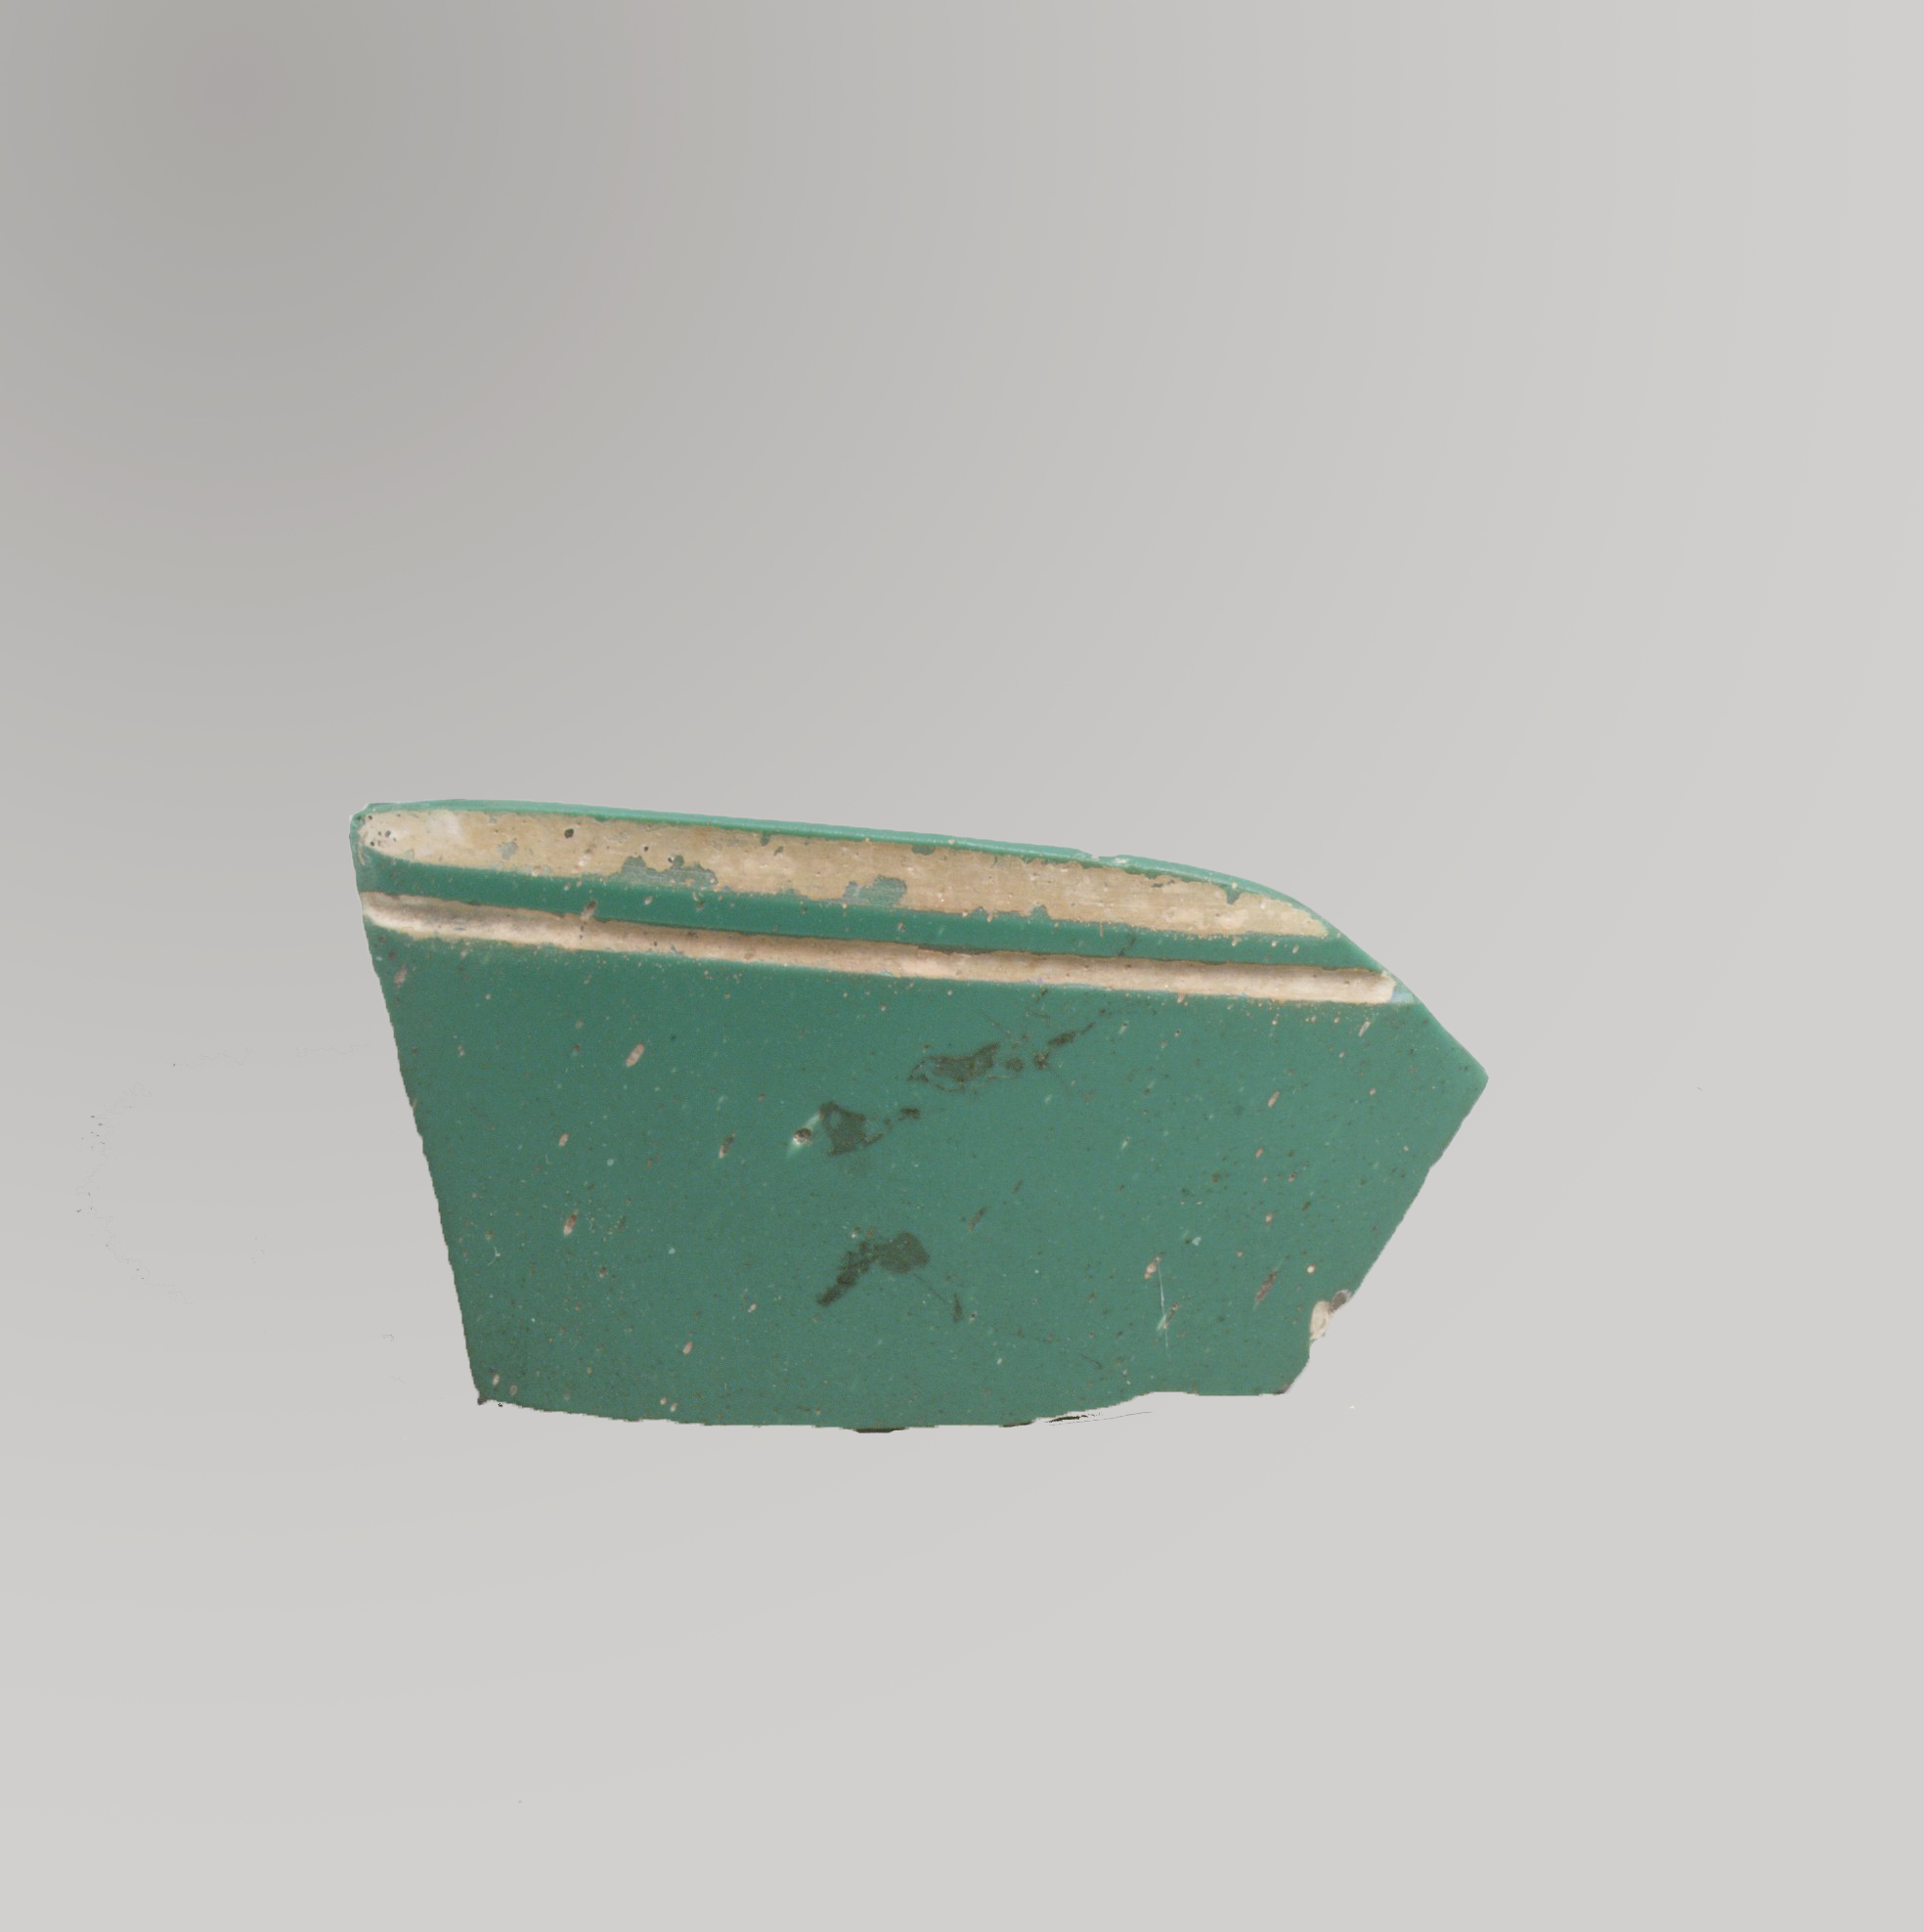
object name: fragment, monochrome bowl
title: Glass monochrome bowl fragment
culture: roman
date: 1-50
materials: glass